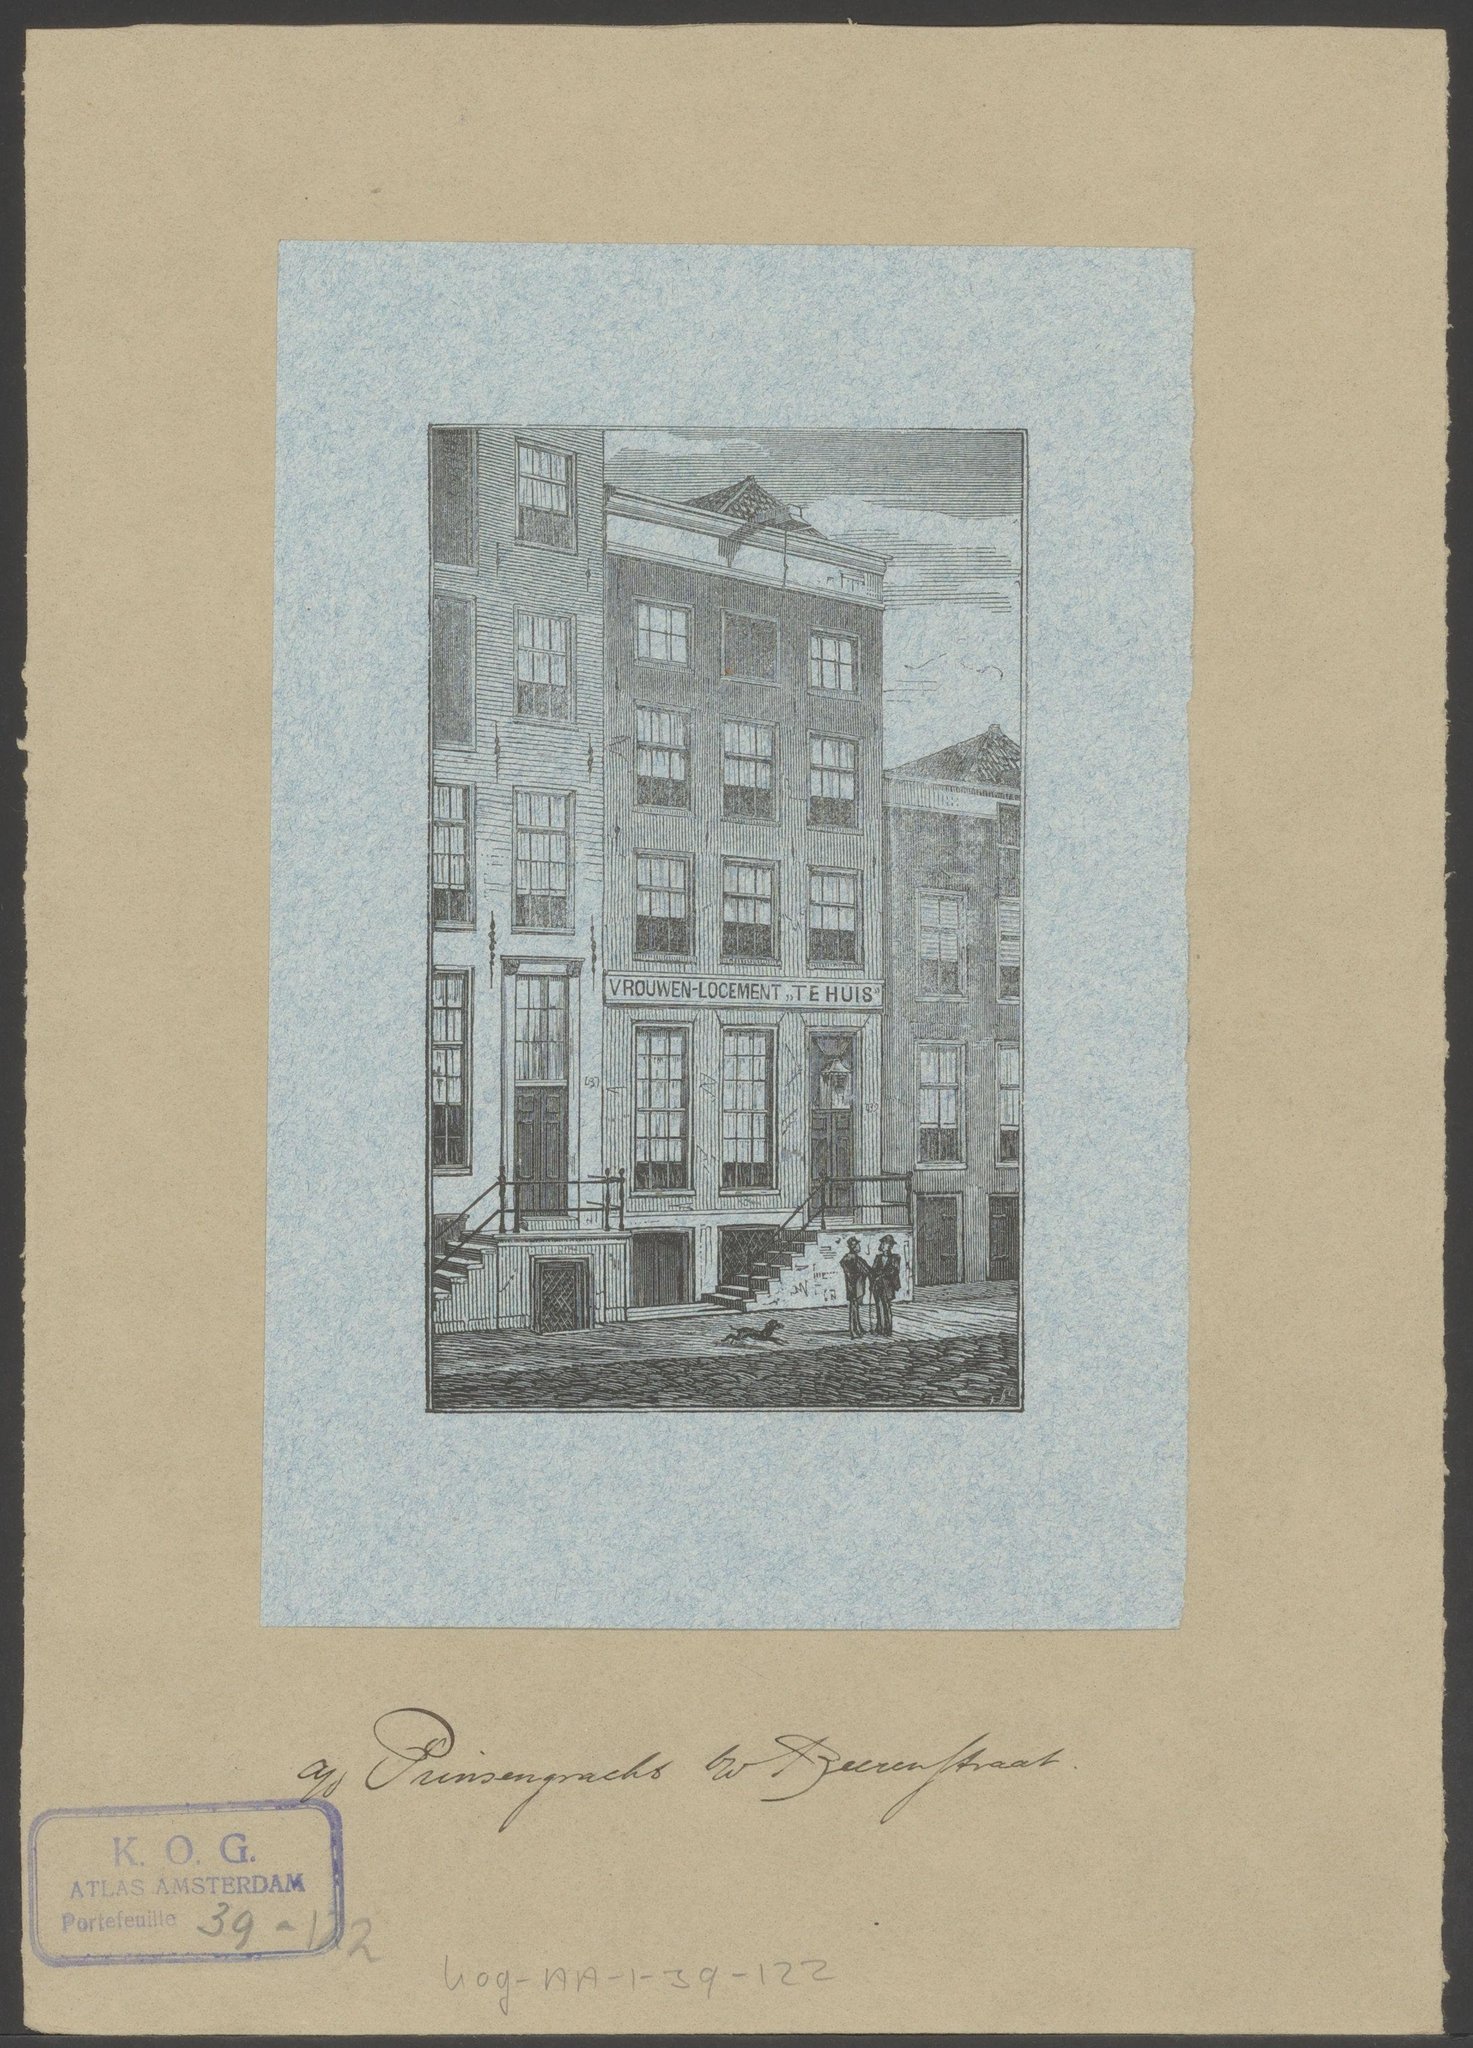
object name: print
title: Gezicht op vrouwenlogement Te Huis te Amsterdam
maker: Anonymous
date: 1871-1900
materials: paper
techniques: engraving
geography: netherlands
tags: public welfare, street (+ city(-scape) with figures, staffage)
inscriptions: collector's mark: Lugt 1641b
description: Onderwerpsrubriek binnen de Atlas Amsterdam: Armwezen en liefdadige instellingen: III. Verschillende gestichten en instellingen / Hofjes: Vrouwen-logement ‘Te Huis' - Boddaert Tehuizen - Tehuis “Koningin Wilhelmina” - Zuigelingen-inrichting.